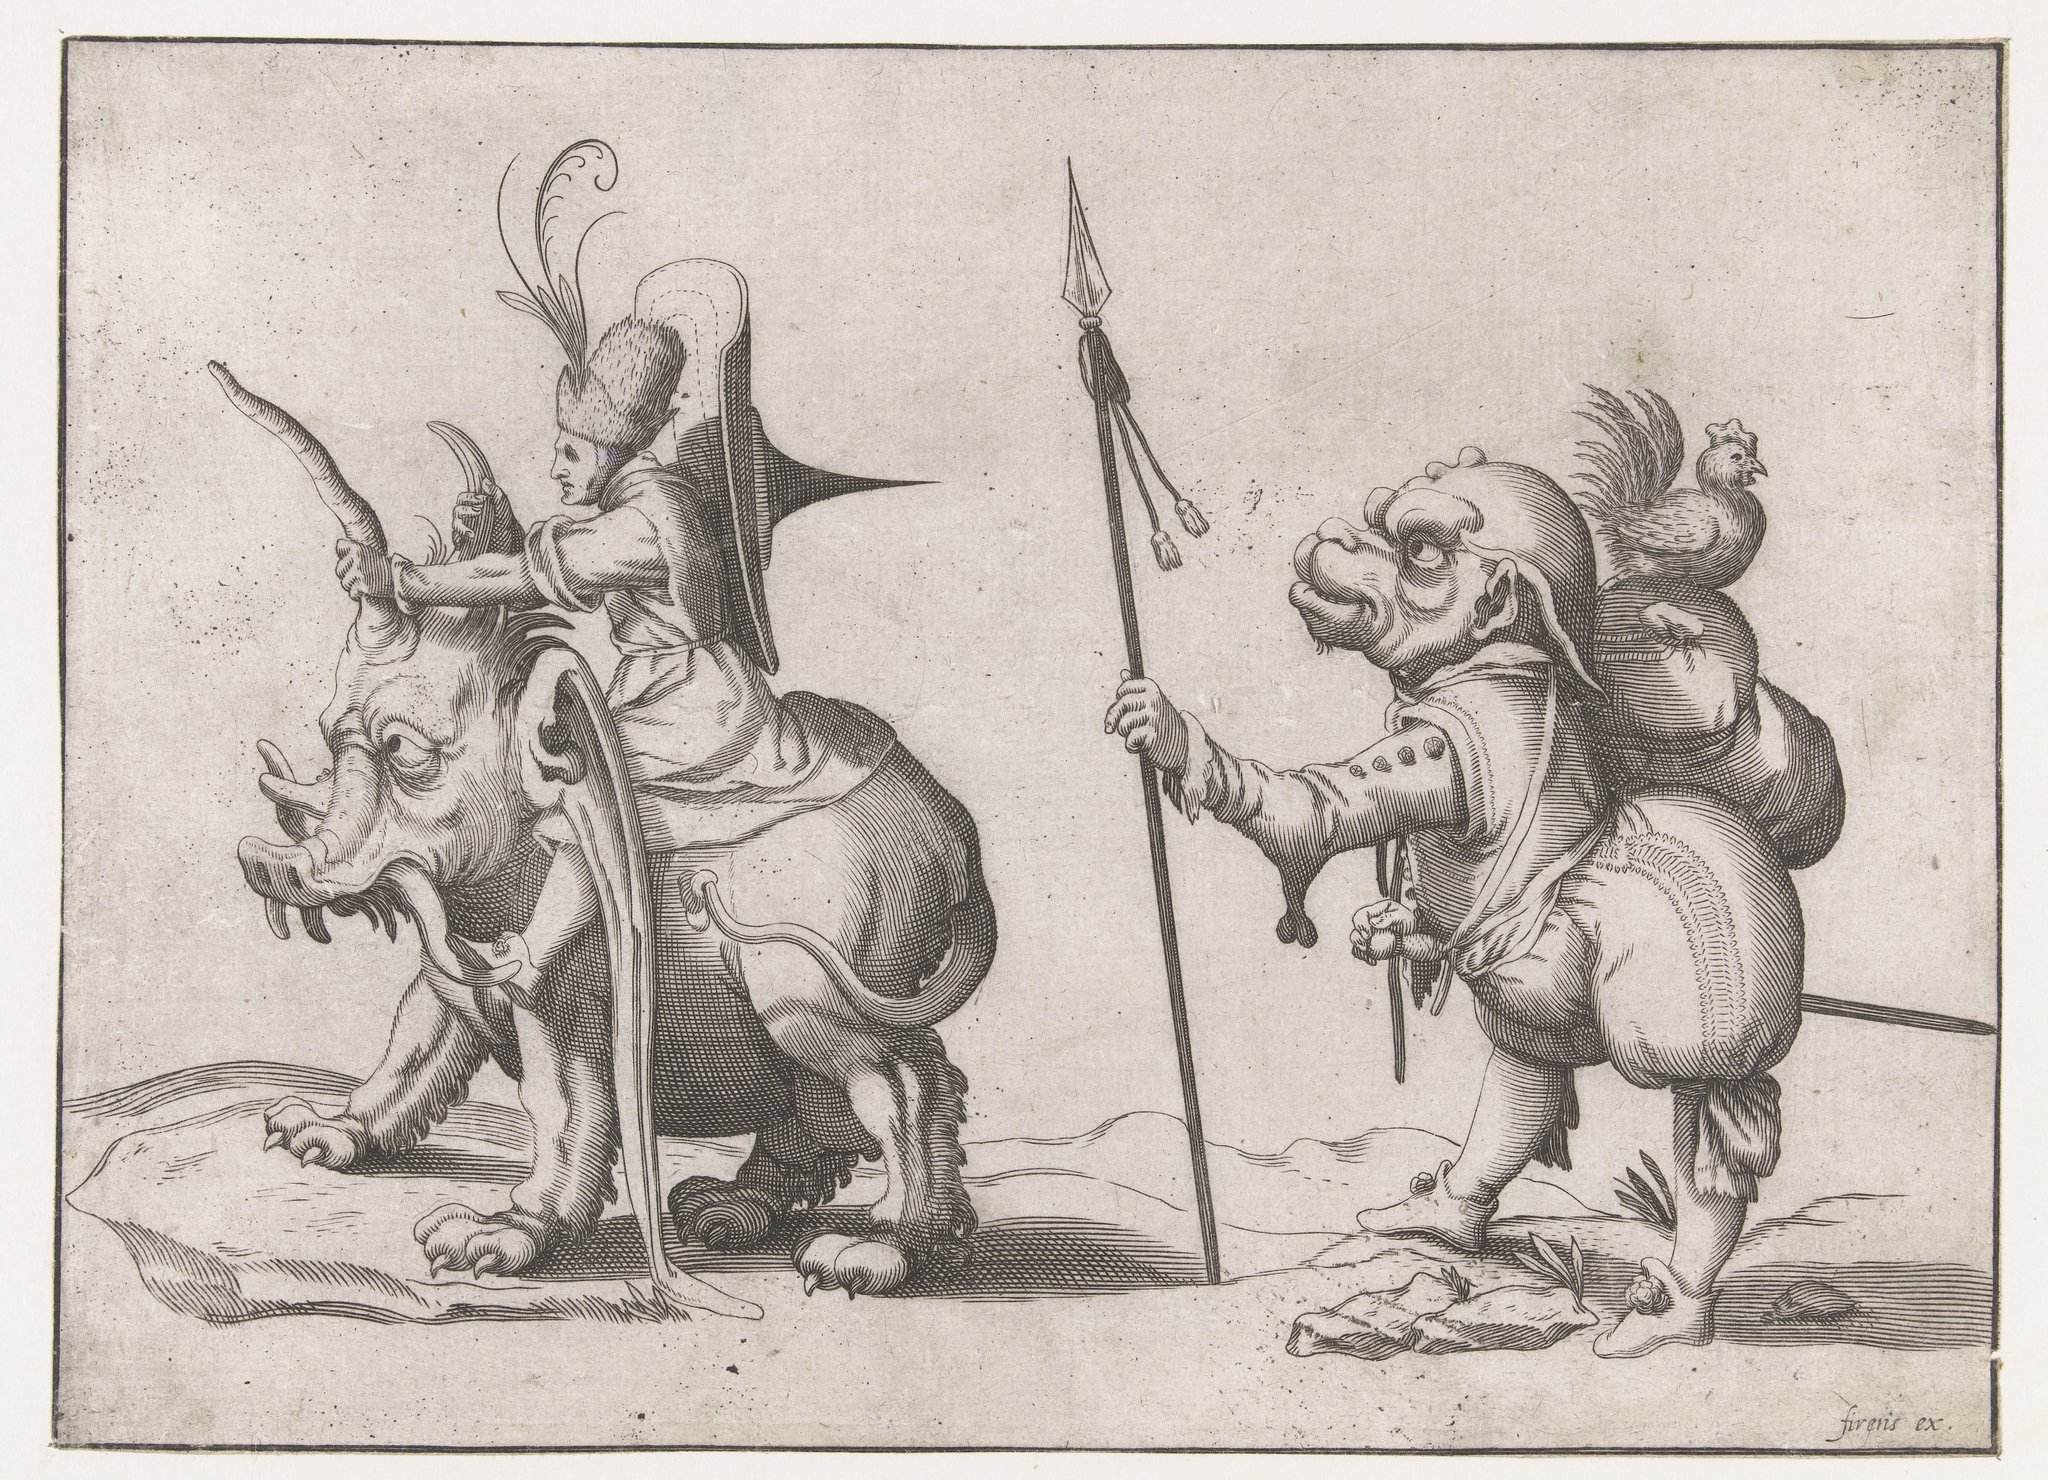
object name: print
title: Reeks van Groteske Figuren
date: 1604-1616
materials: paper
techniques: engraving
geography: paris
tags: ornament ~ grotesque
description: Ruiter op monster in de vorm van een soort oloifant. Rechts een monster met een lans en een buidel op zijn rug, waarop een kip zit. No. 2 serie van 7 bladen